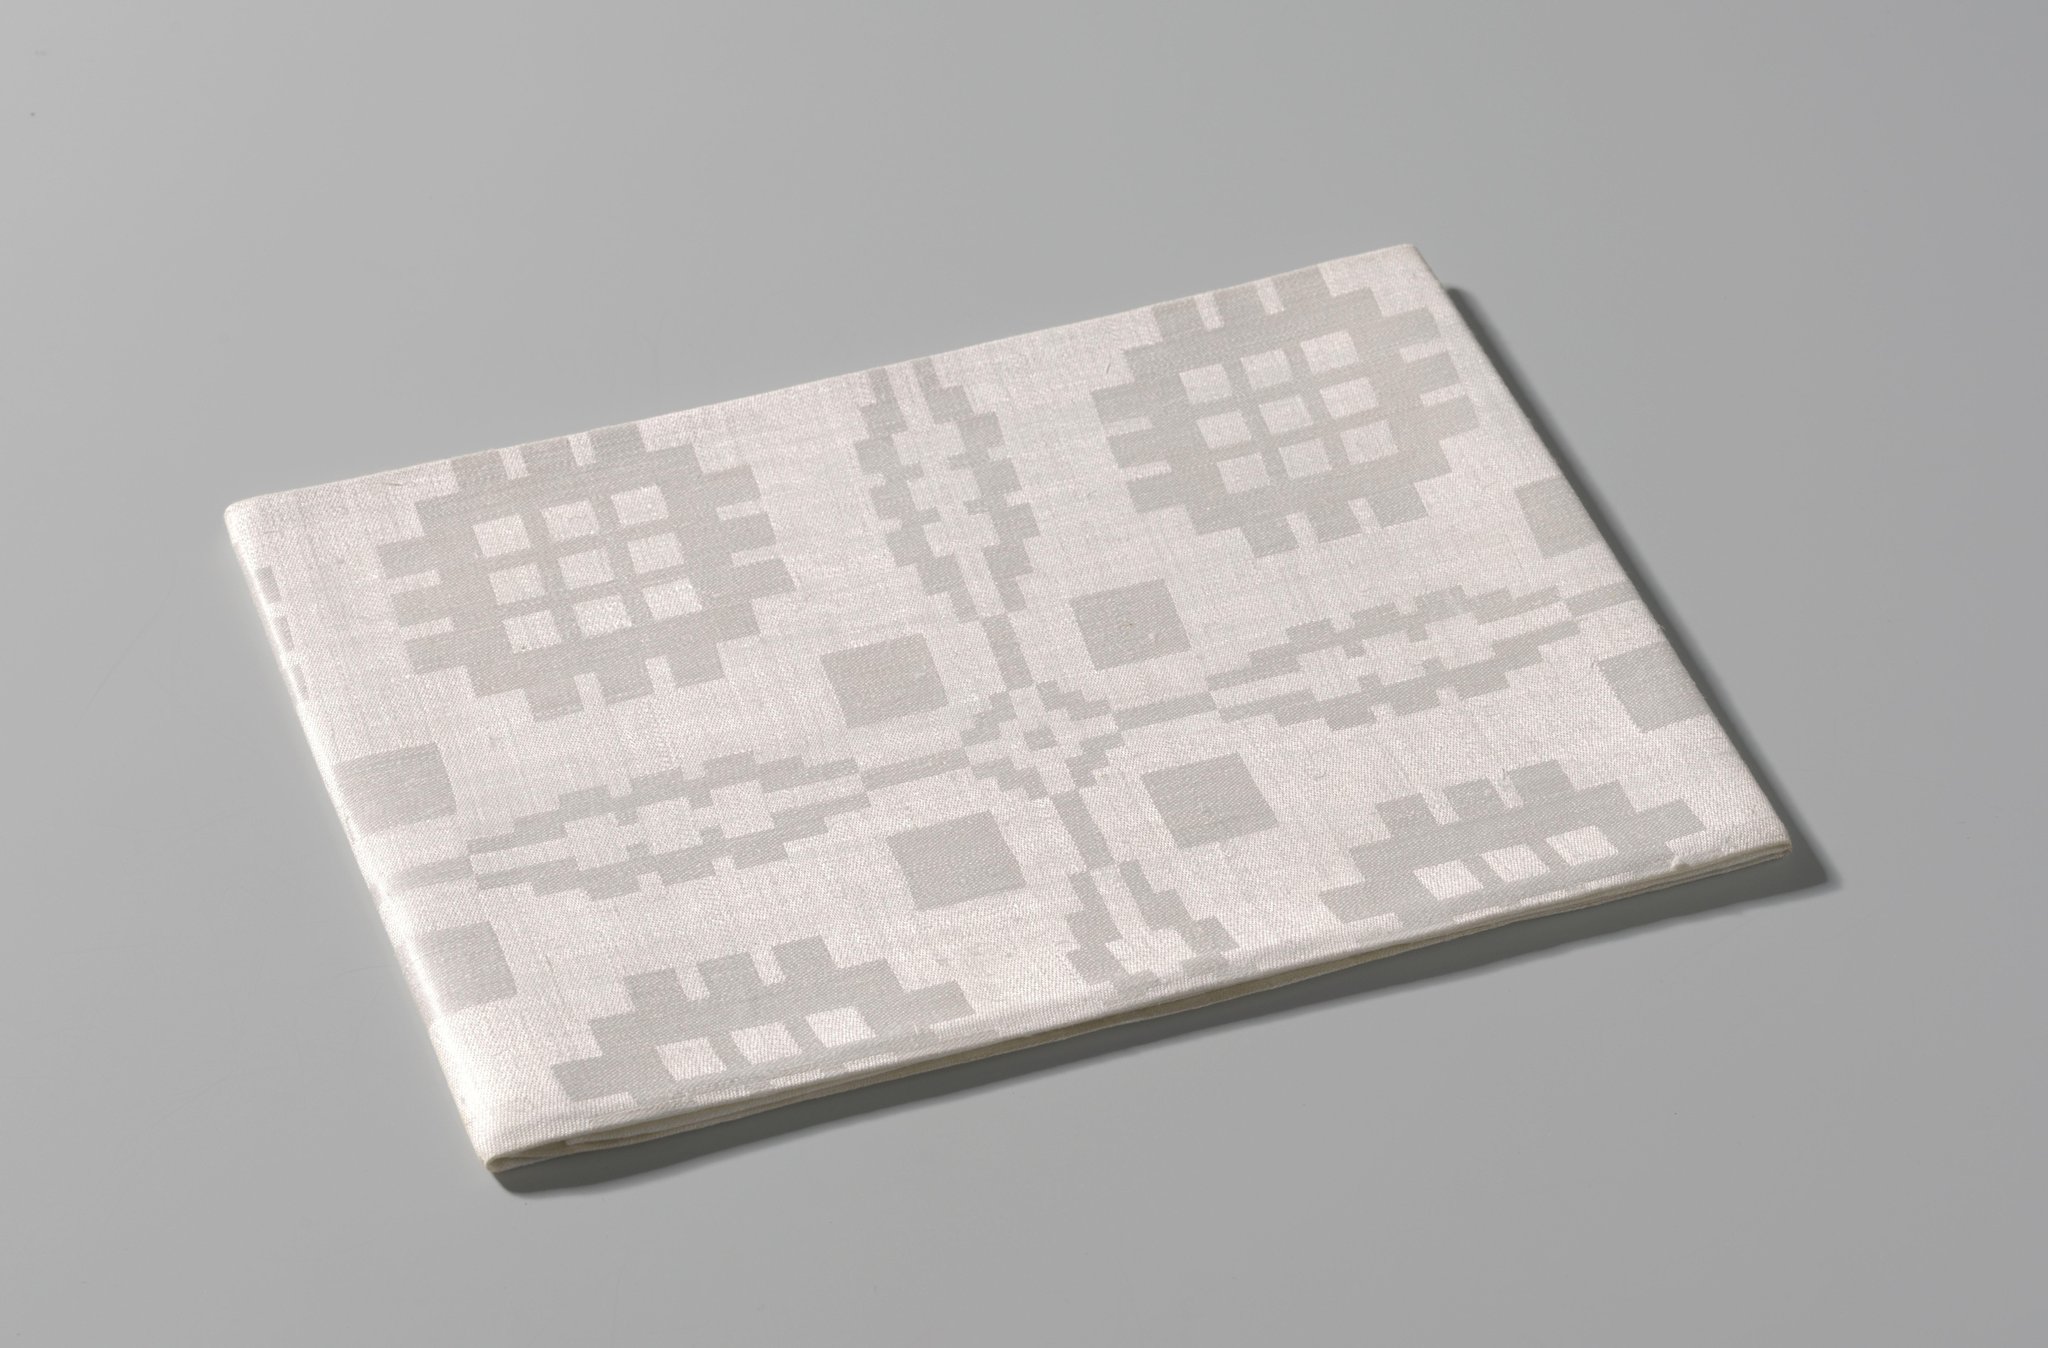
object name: napkin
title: Servet van linnen met pellenpatroon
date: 1730-1786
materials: linen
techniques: peeled fabric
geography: northern netherlands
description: Wit linnen servet met pellen patroon, merk kroon IAVG 12.